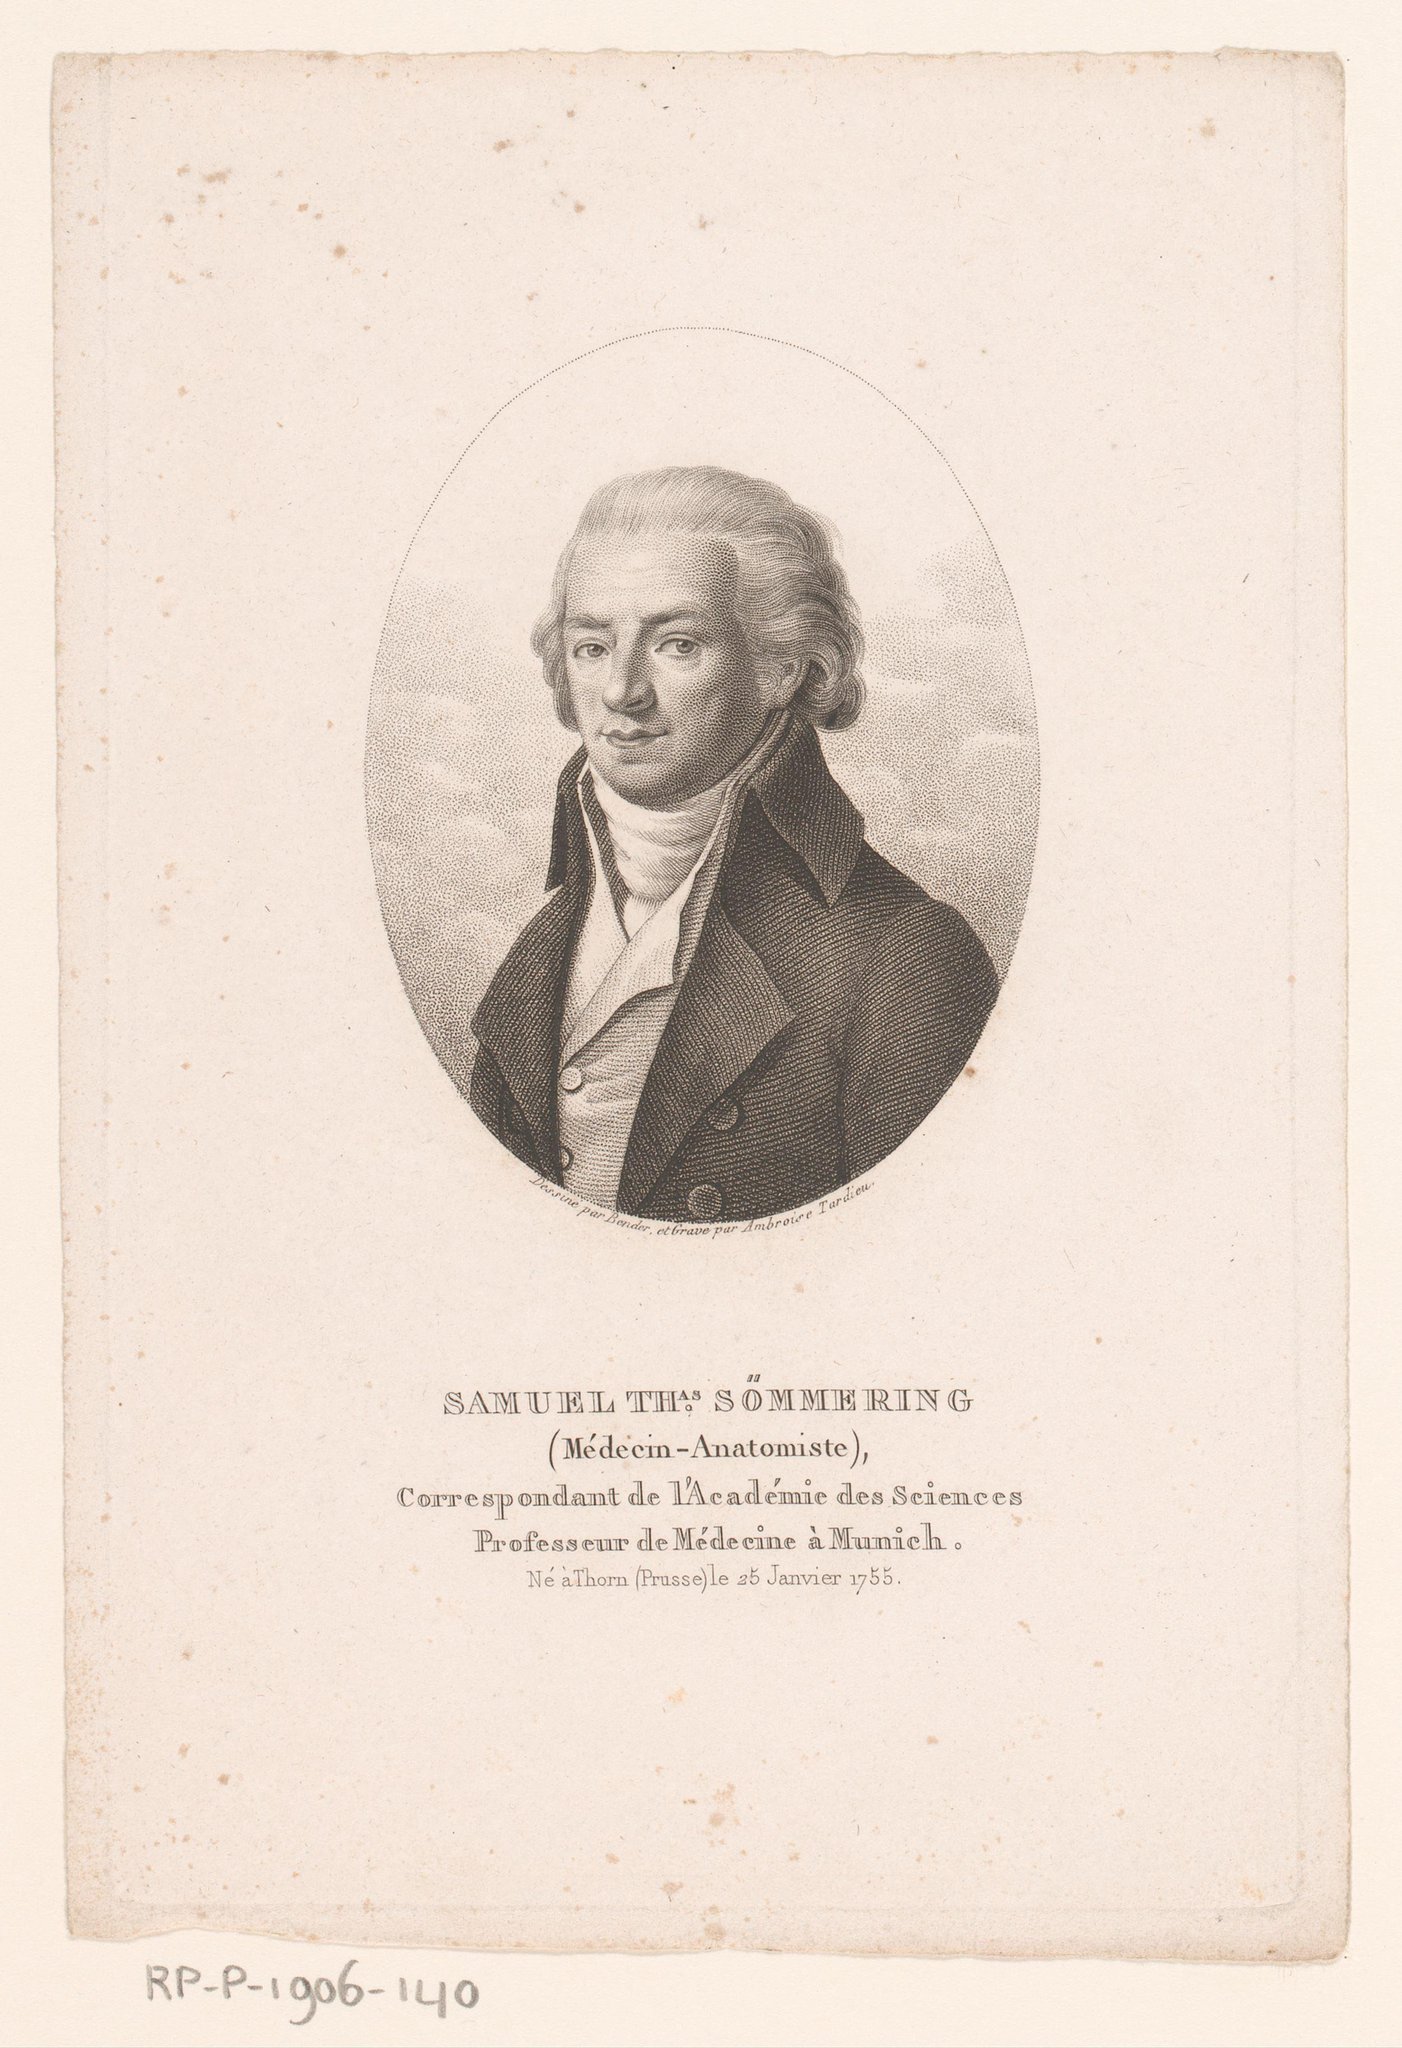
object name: print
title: Compleet overzicht van beroemdheden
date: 1820-1828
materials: paper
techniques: engraving, roulette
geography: paris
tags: physicist, historical persons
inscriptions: collector's mark: Lugt 2228